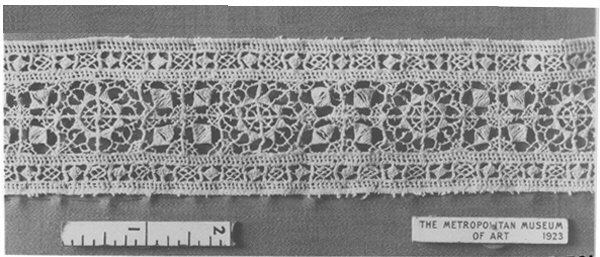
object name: strip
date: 1600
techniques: lace